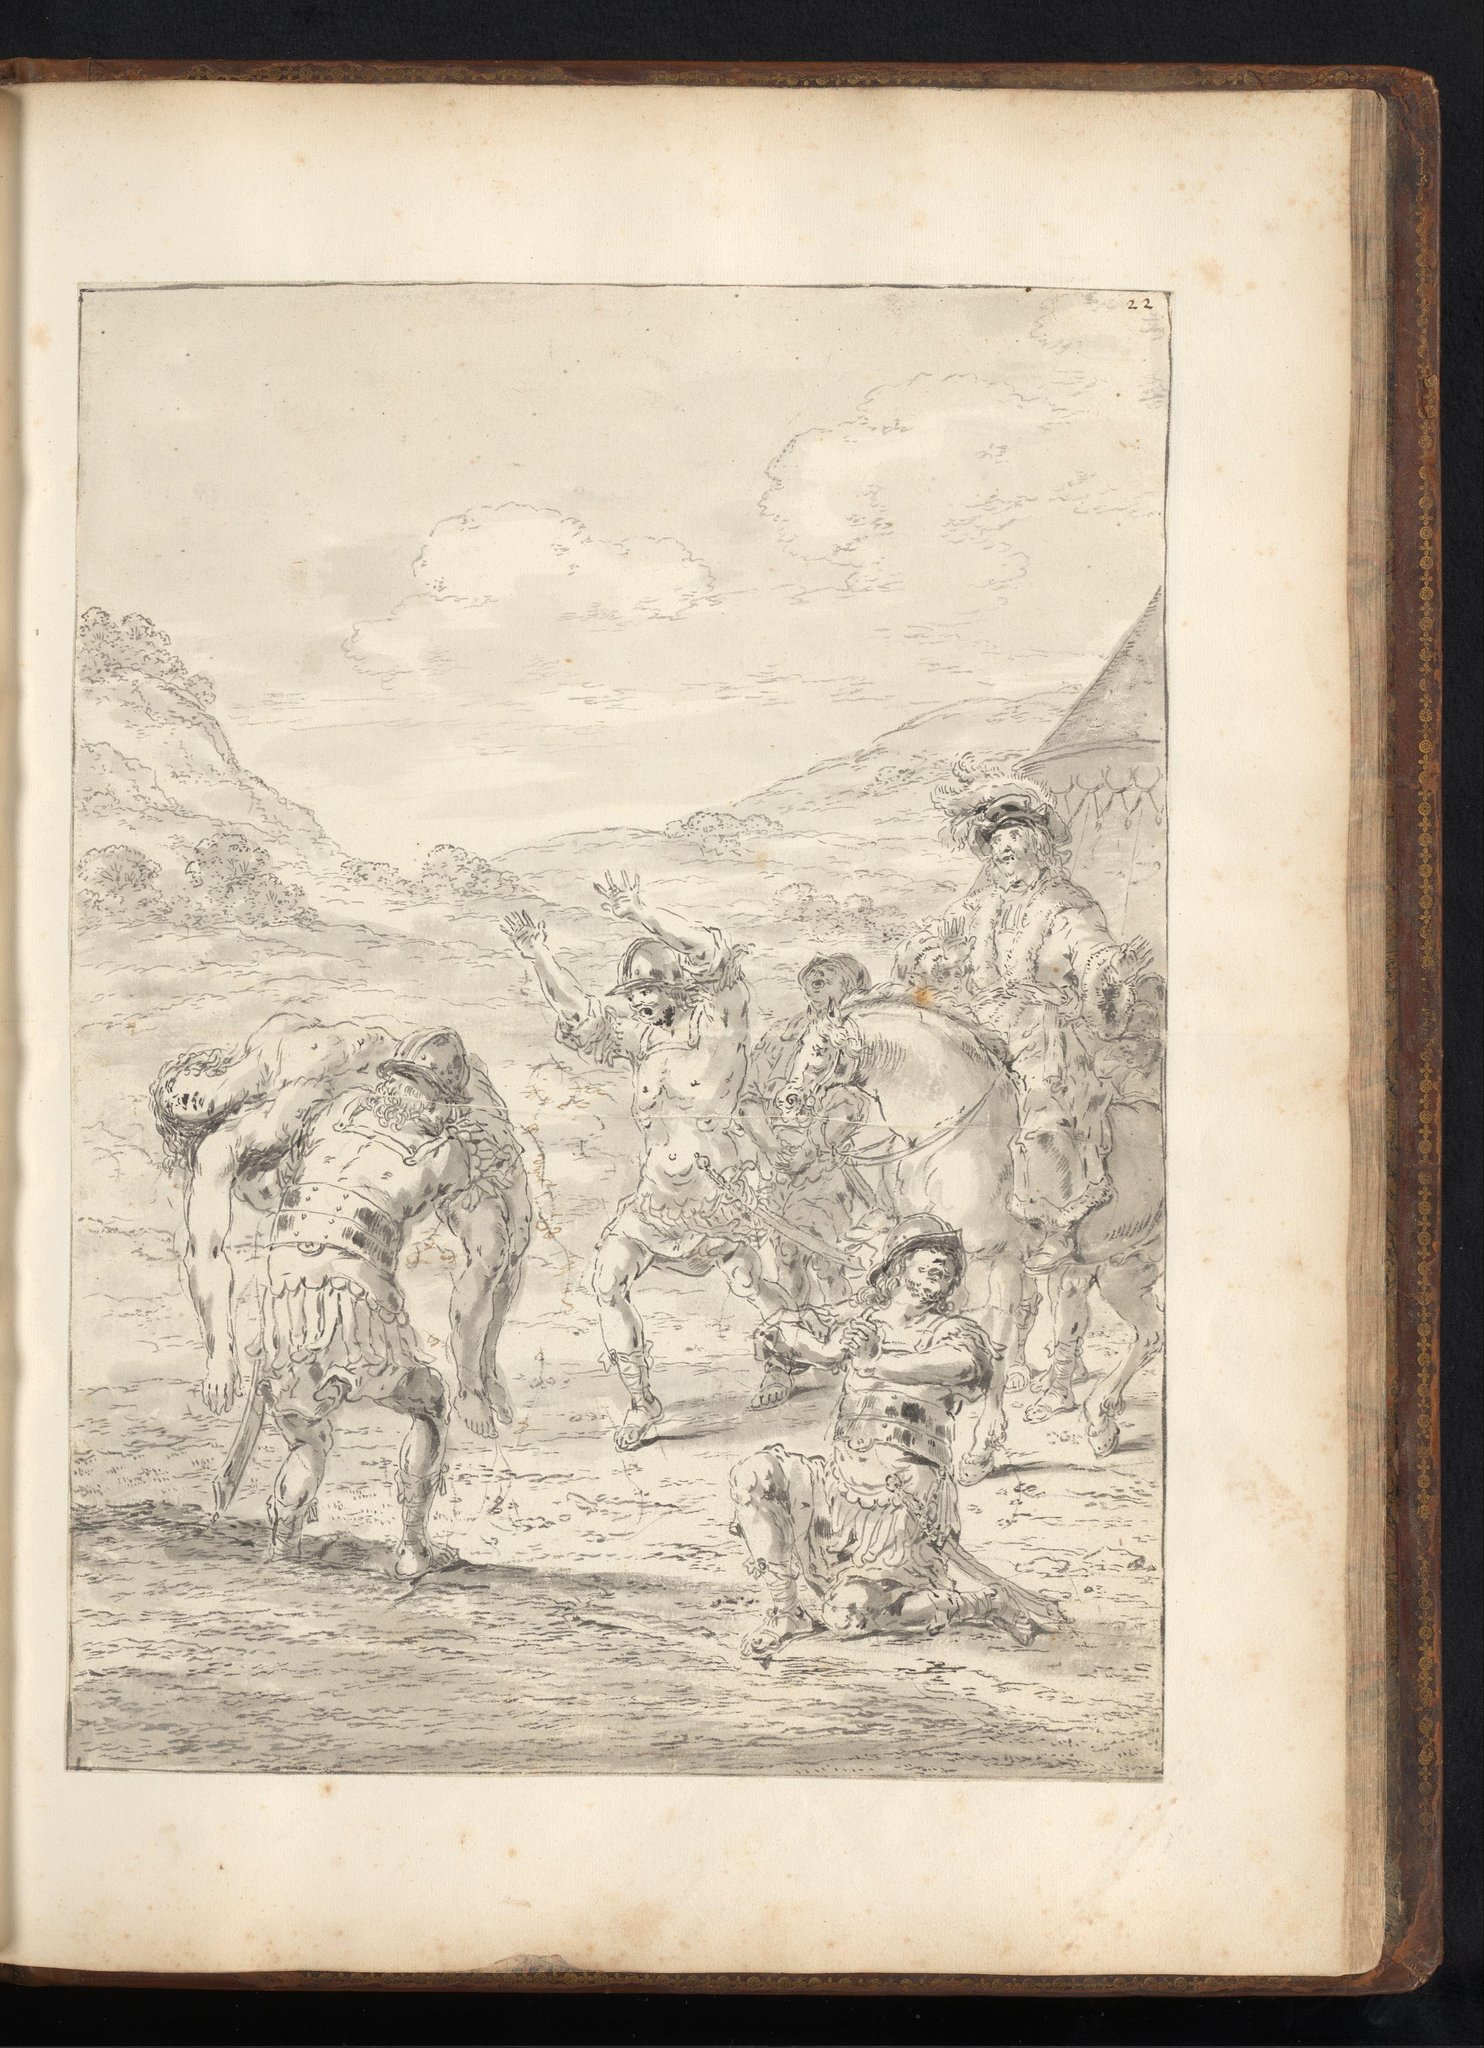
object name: drawing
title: Alexander de Grote wordt uit de Cydnus gedragen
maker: leonaert bramer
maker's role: draughtsman, painter, print maker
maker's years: 1596-1674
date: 1655-1665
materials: ink, paper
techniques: brush, pen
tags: alexander is being rescued from drowning in the river cydnus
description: Alexander de Grote nam een bad in de rivier de Cydnus om af te koelen van koorts, maar raakte verstijfd en buiten bewustzijn door het koude water. Links wordt Alexander door één van zijn soldaten uit het water gedragen, rechts komen andere soldaten te hulp gerend. De soldaat rechts op de voorgrond knielt met de handen in elkaar geslagen. Rechtsboven genummerd: 22. Tekening maakt deel uit van een album.